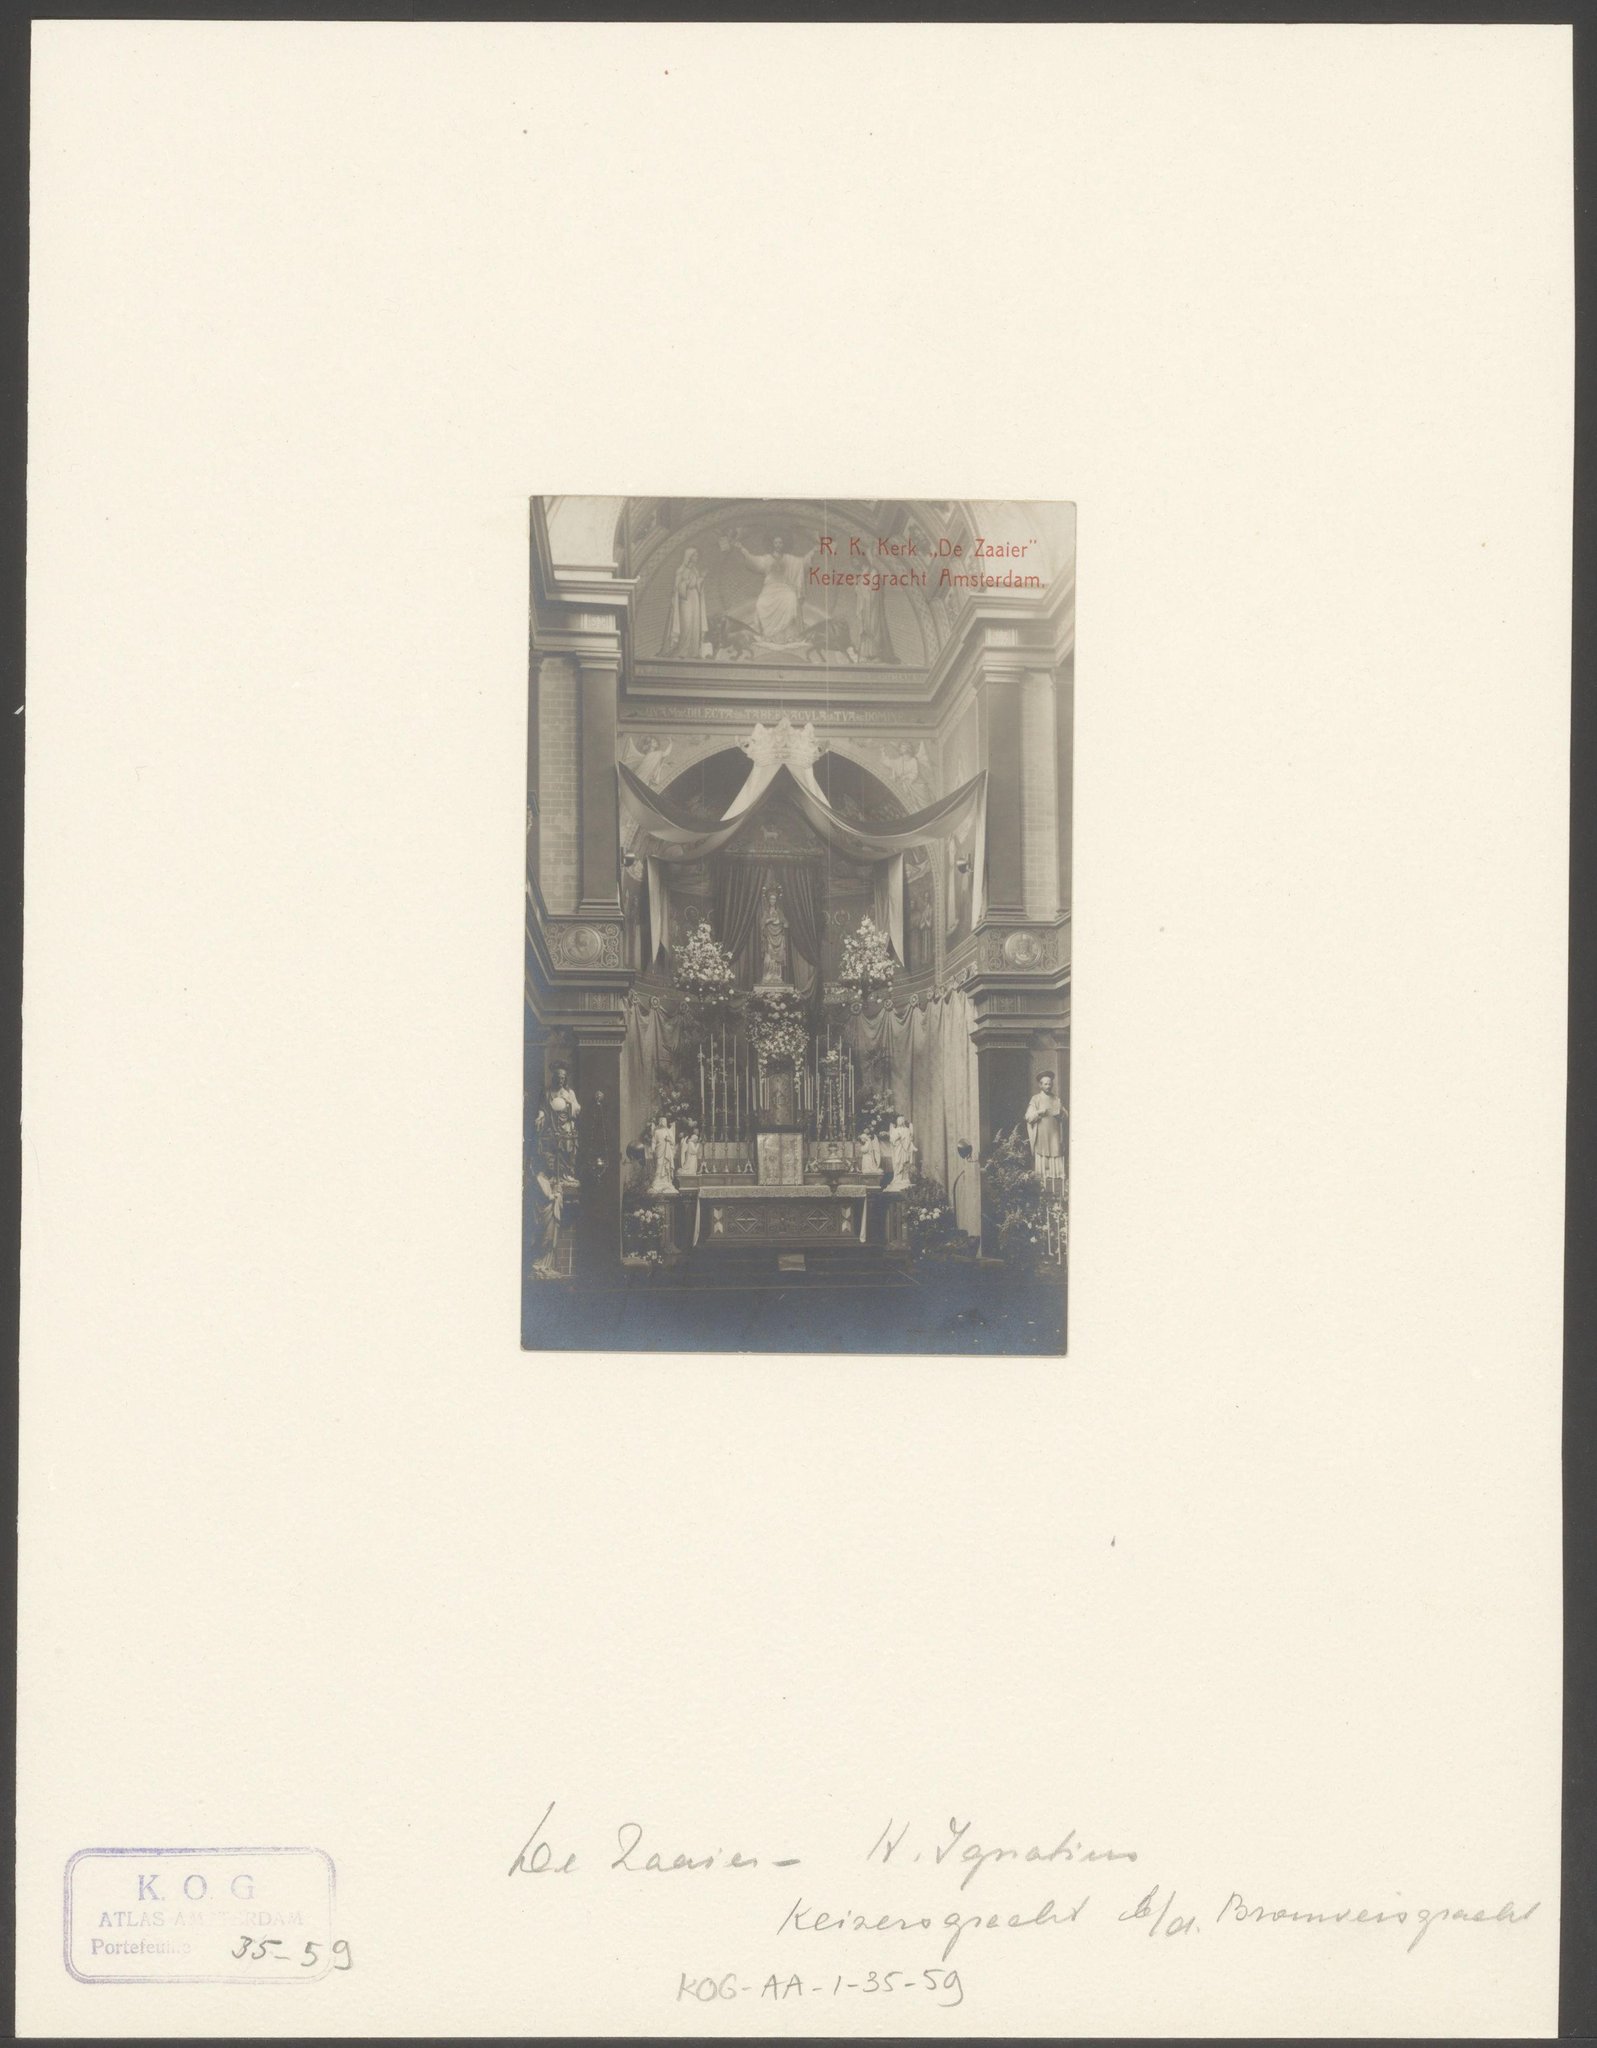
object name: ansichtkaart, prentbriefkaart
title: Gezicht op het altaar van de Sint-Ignatiuskerk (De Zaaier) te Amsterdam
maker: Anonymous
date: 1900-1930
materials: paper, cardboard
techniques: gelatin silver print, letterpress printing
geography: amsterdam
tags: parts of church interior: aisle, fixed altar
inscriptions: collector's mark: ‘35-59’ Lugt 1641b, collector's mark: ‘17’ Lugt 1641b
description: Onderwerpsrubriek binnen de Atlas Amsterdam: R.K. Gemeenten: Sint Nicolaaskerk t/m Willibrordus (Rustenburgerstraat).